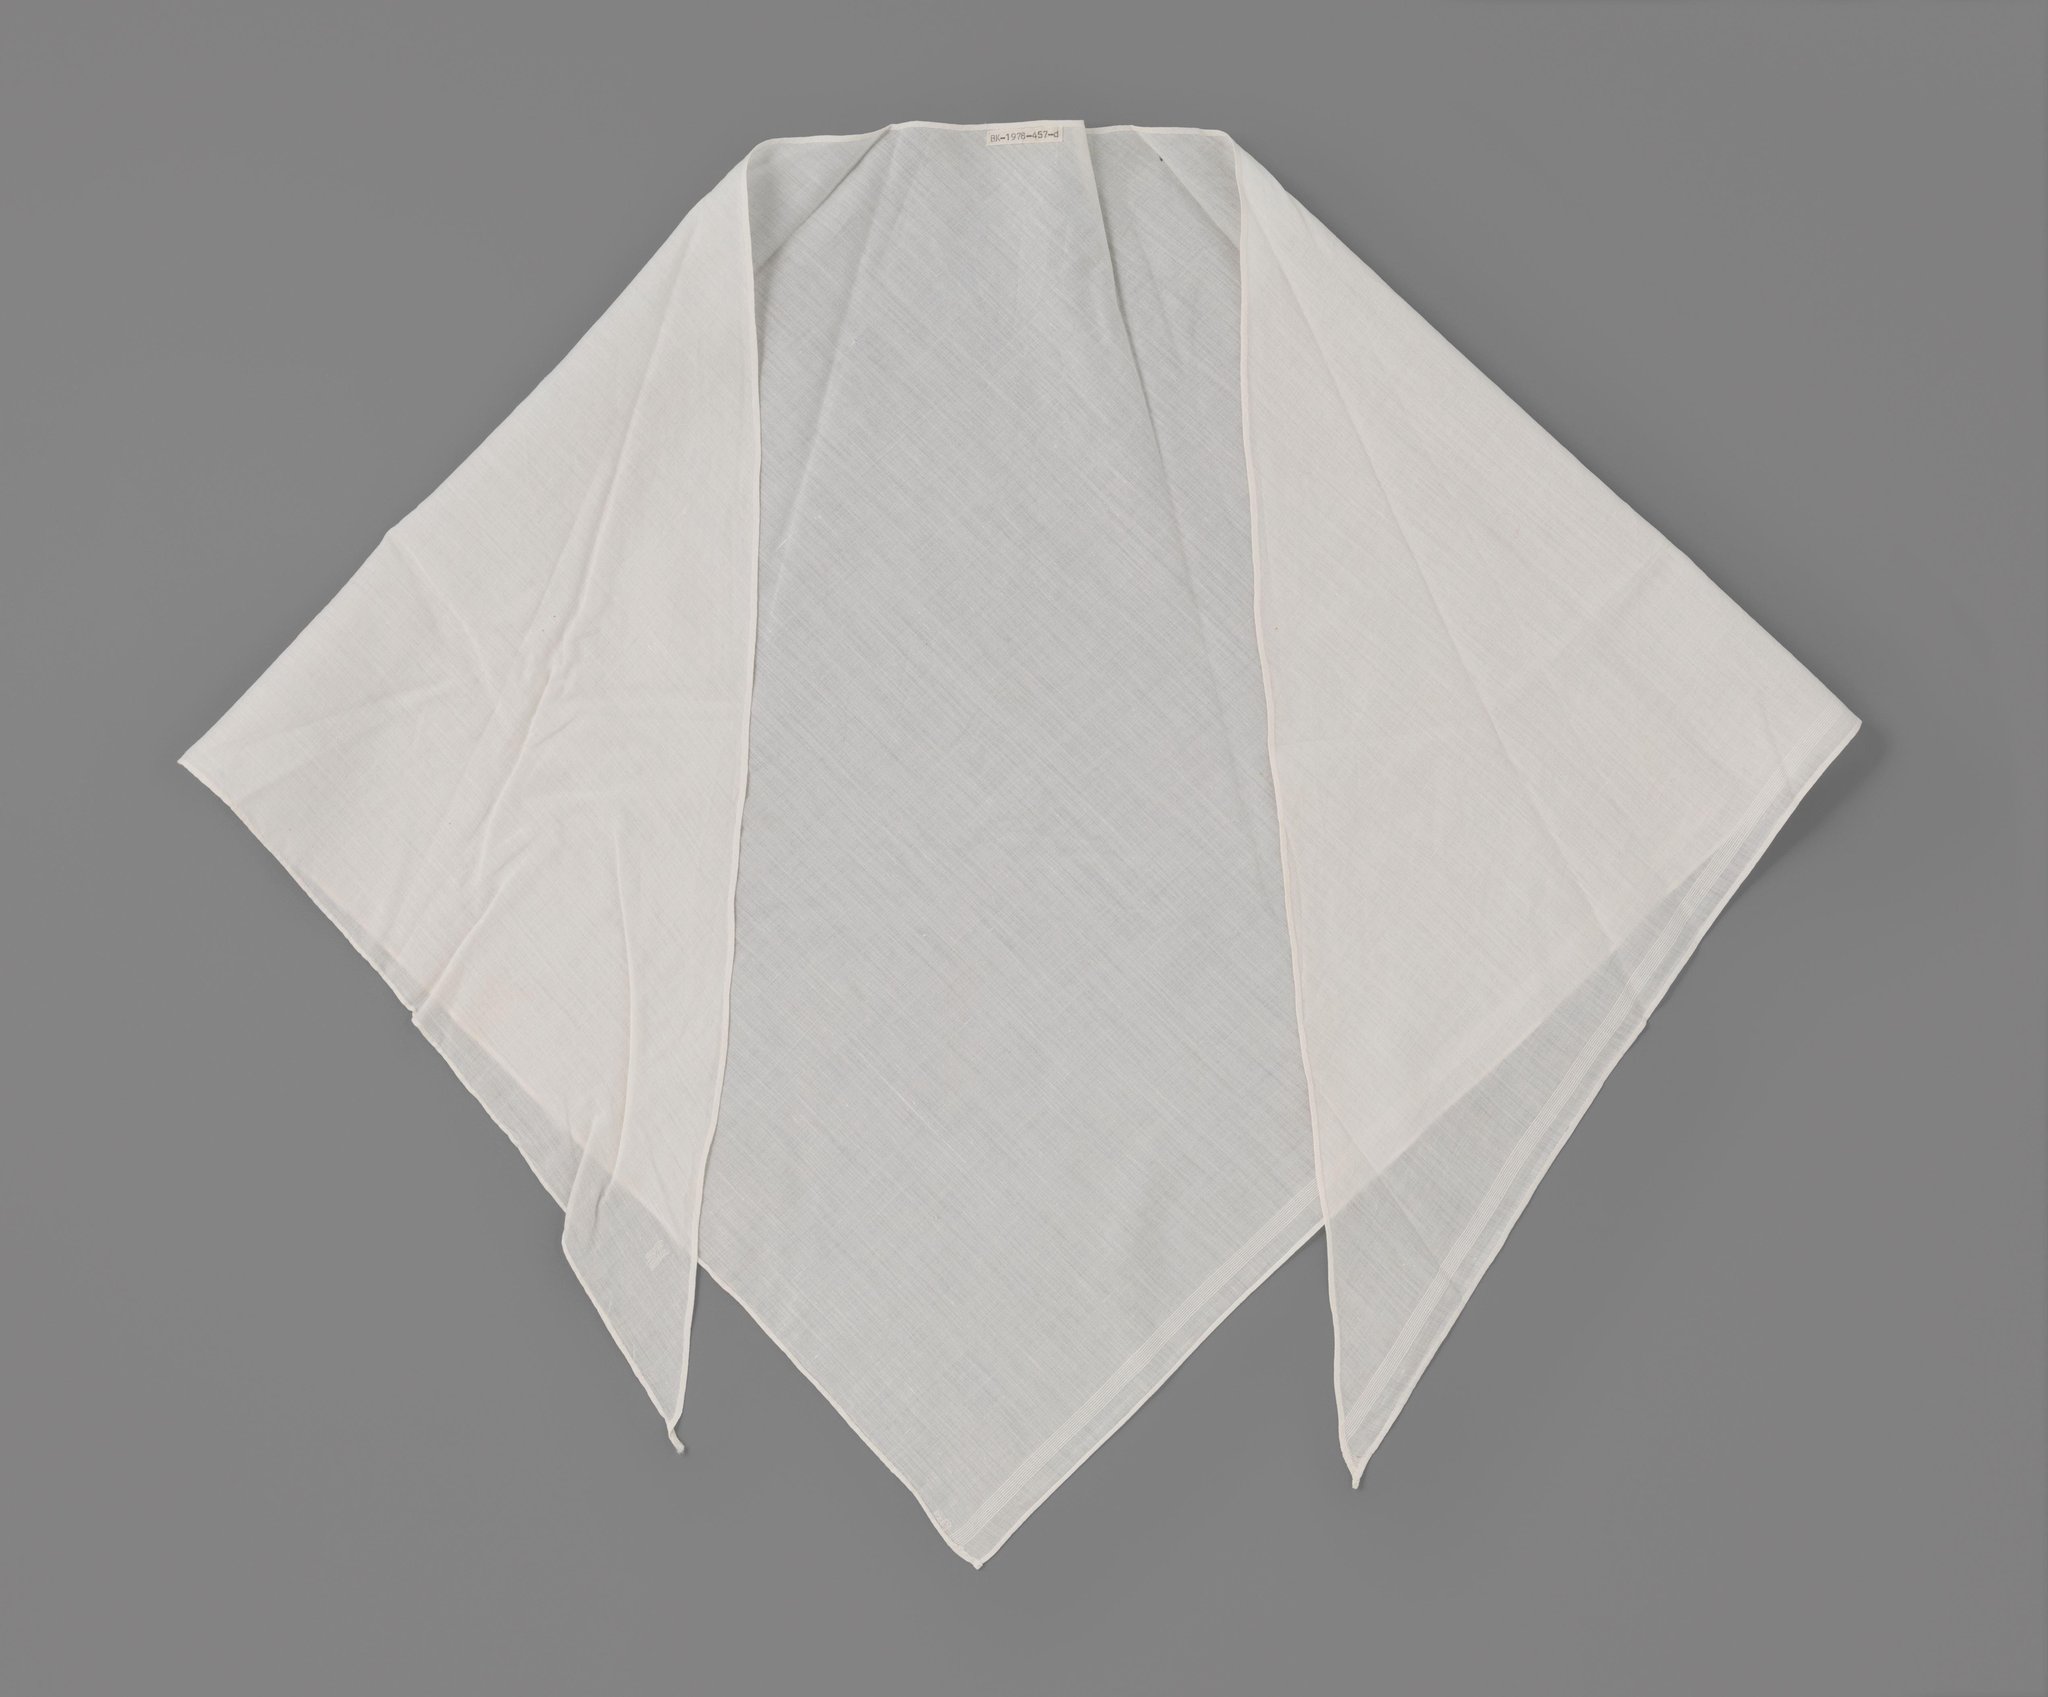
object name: fichu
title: Fichu van katoen, driehoekig, met rondom een rand van streepbiezen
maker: Anonymous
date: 1890-1900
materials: cotton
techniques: cross stitching, embroidered, weave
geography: amsterdam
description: Fichu van katoen, driehoekig, met rondom een rand van streepbiezen. Model: alle zijden met een platte zoom. Schuin op de draad gewerkt. In de punt met kleine kruissteken (rood en wit) gemerkt 'CB/ 12' of 'OB/ 12'.